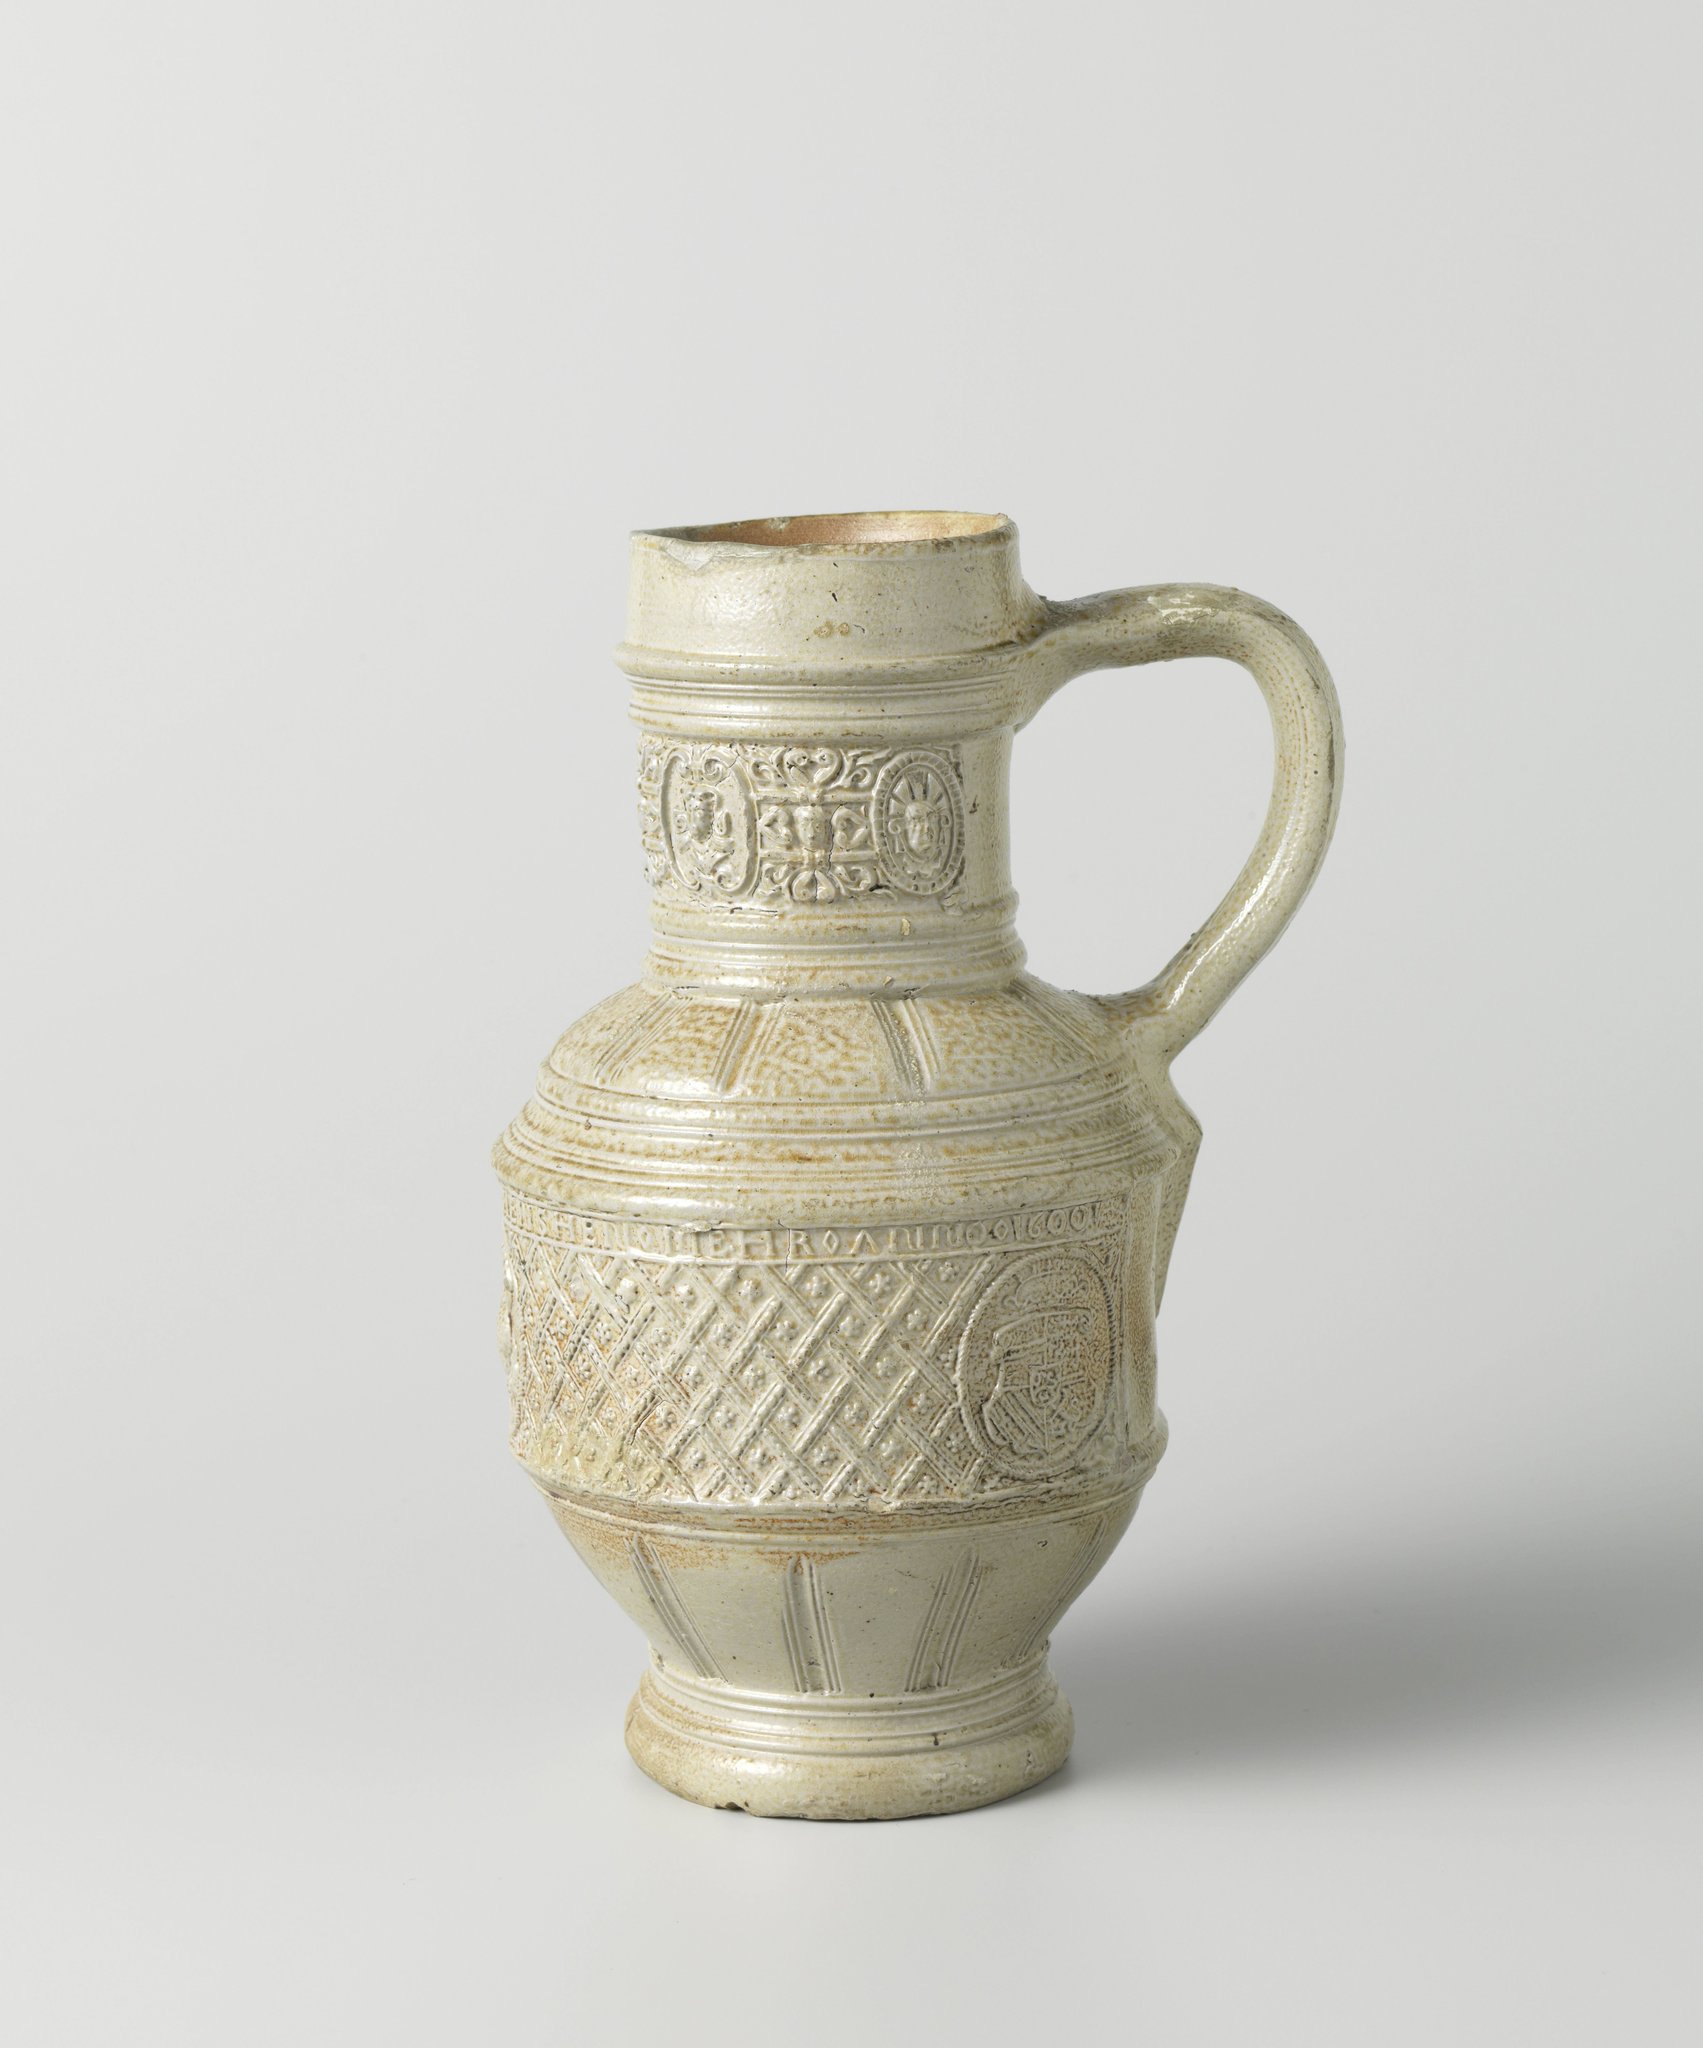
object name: jug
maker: Anonymous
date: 1600-1610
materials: glaze, stoneware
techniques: firing, forming, relief, turning, vitrification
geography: raeren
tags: mask, mascaron ~ ornament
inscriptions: mark: ‘H.K.’, inscription: ‘GOTT ALLEIN DIE EHR VND GEINE MENSHEN MEHR ANNO 1600’, date: ‘1600’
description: Kruik van steengoed op hoge voet met een cilindrisch lichaam, ronde schouder en wijde, geribde nek. Profielen op het lichaam en de voet. Op de buik in reliëf een gedrukte en opgelegde band met rozetten in gevlochten ruiten, onderbroken door drie medaillons. Het middelste medaillon met de pelikaan die haar jongen uit haar borst voedt. Links een wapen met het merk 'H.K.' en rechts een ander wapen. Hierboven het opschrift 'GOTT ALLEIN DIE EHR VND GEINE MENSHEN MEHR ANNO 1600'. Het onderste deel van de buik loopt schuin af en is verdeeld in ingegrifte vakken, net als de schouder. Op de nek een band in reliëf met maskers in medaillons, verbonden door rolwerk en bladranken. Raeren.